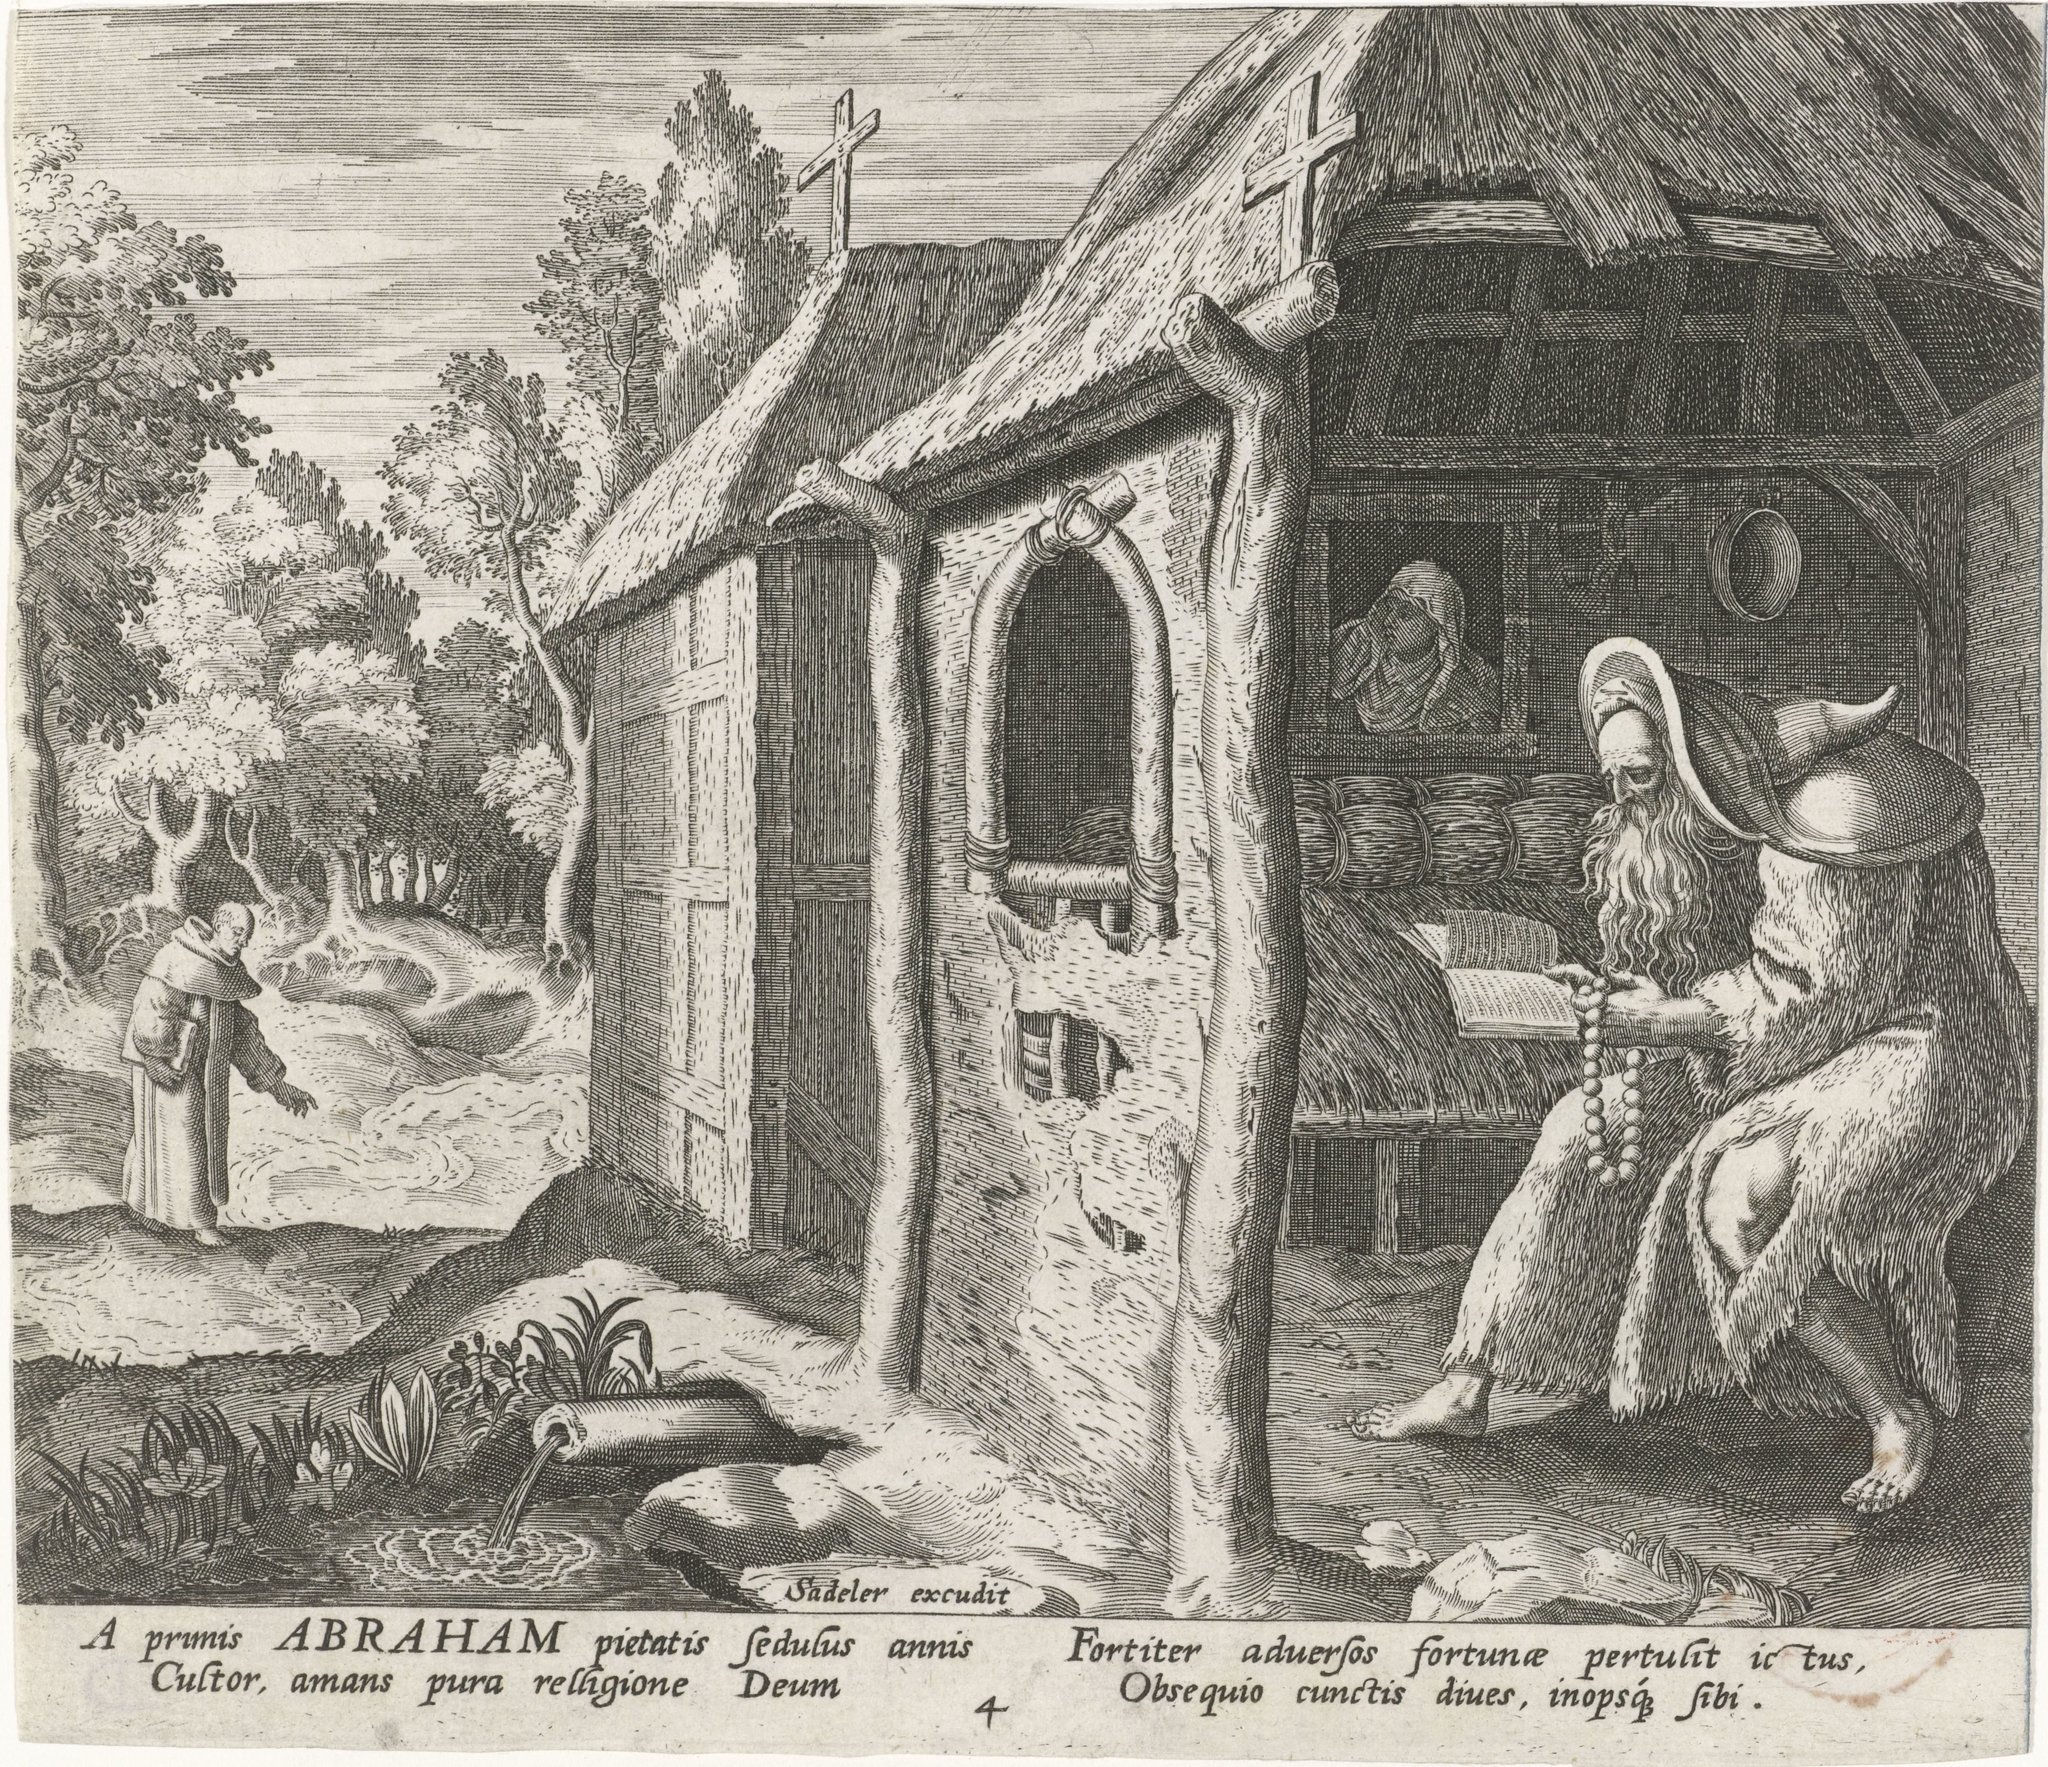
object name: print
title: Solitudo Sive Vitae Patrum Eremicolarum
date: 1583-1588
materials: paper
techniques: engraving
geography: antwerp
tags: anchorite, hermit, male saints (with name)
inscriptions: collector's mark: Lugt 2228, collector's mark: Lugt 240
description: De H. Abraham als kluizenaar in een hutje. Hij leest uit een bijbel en heeft een rozenkrans vast. Achter hem zijn nicht, de H. Maria van Edessa. Op de achtergrond wandelt een monnik.